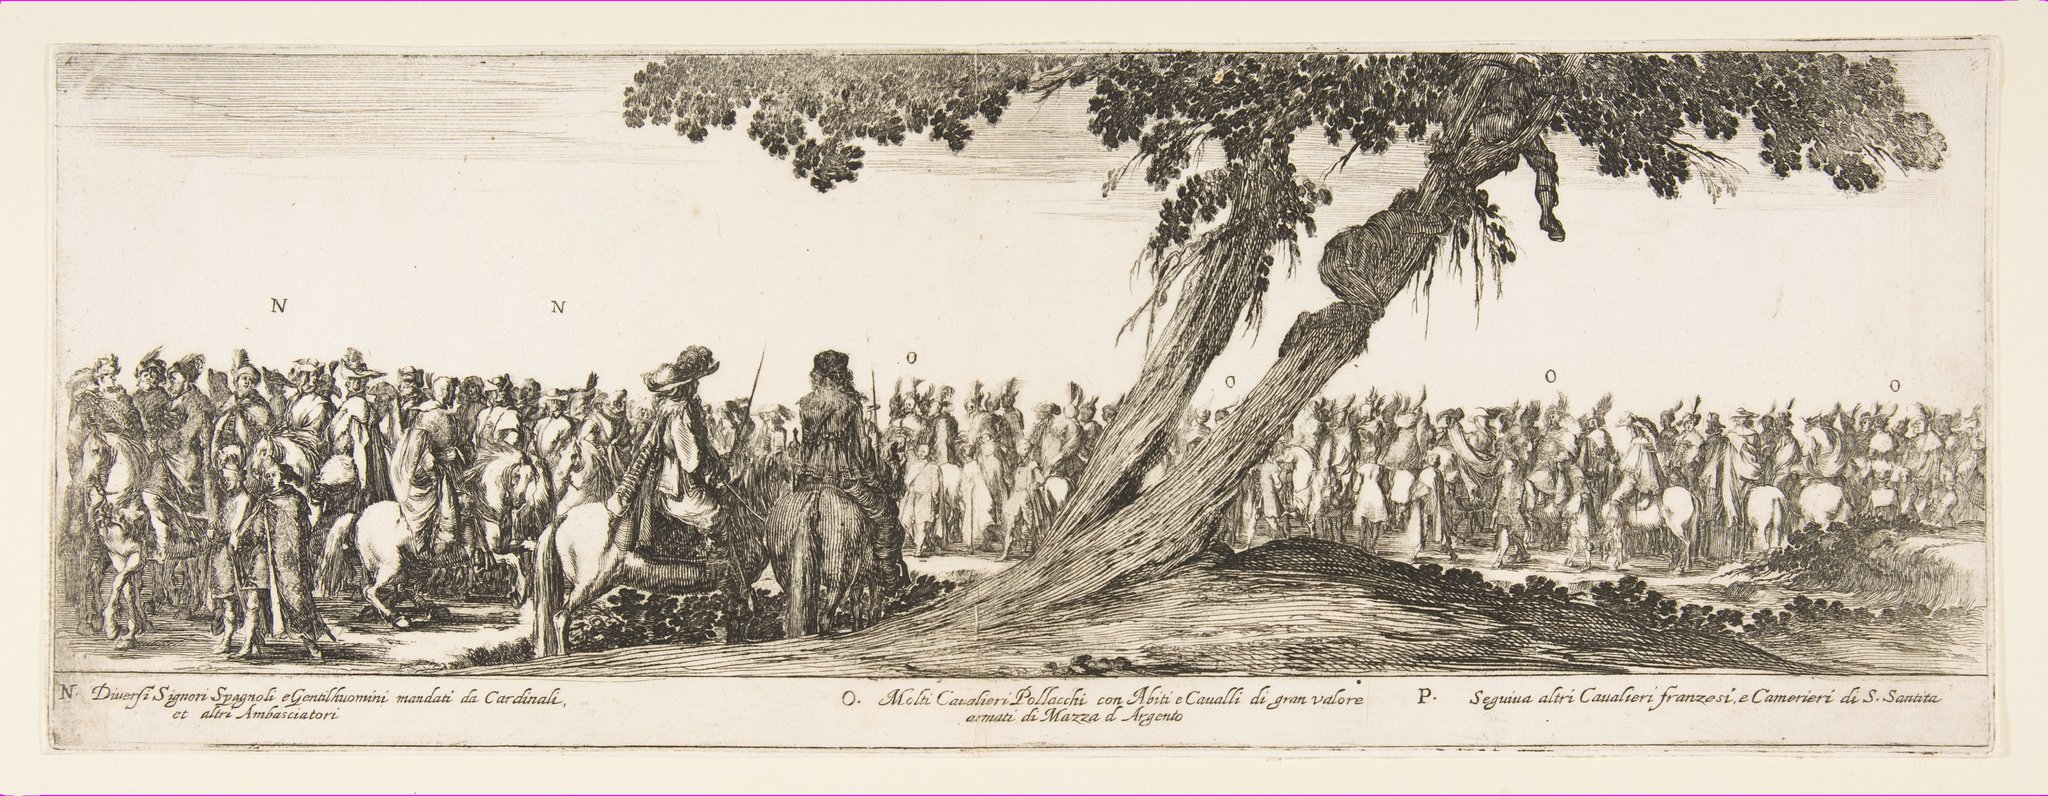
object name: print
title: Part of the Entrance of the Polish Legation (N. O. P.)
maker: stefano della bella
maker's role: artist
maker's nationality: italian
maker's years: 1610-1664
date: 1633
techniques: etching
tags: human figures,weapons,horses